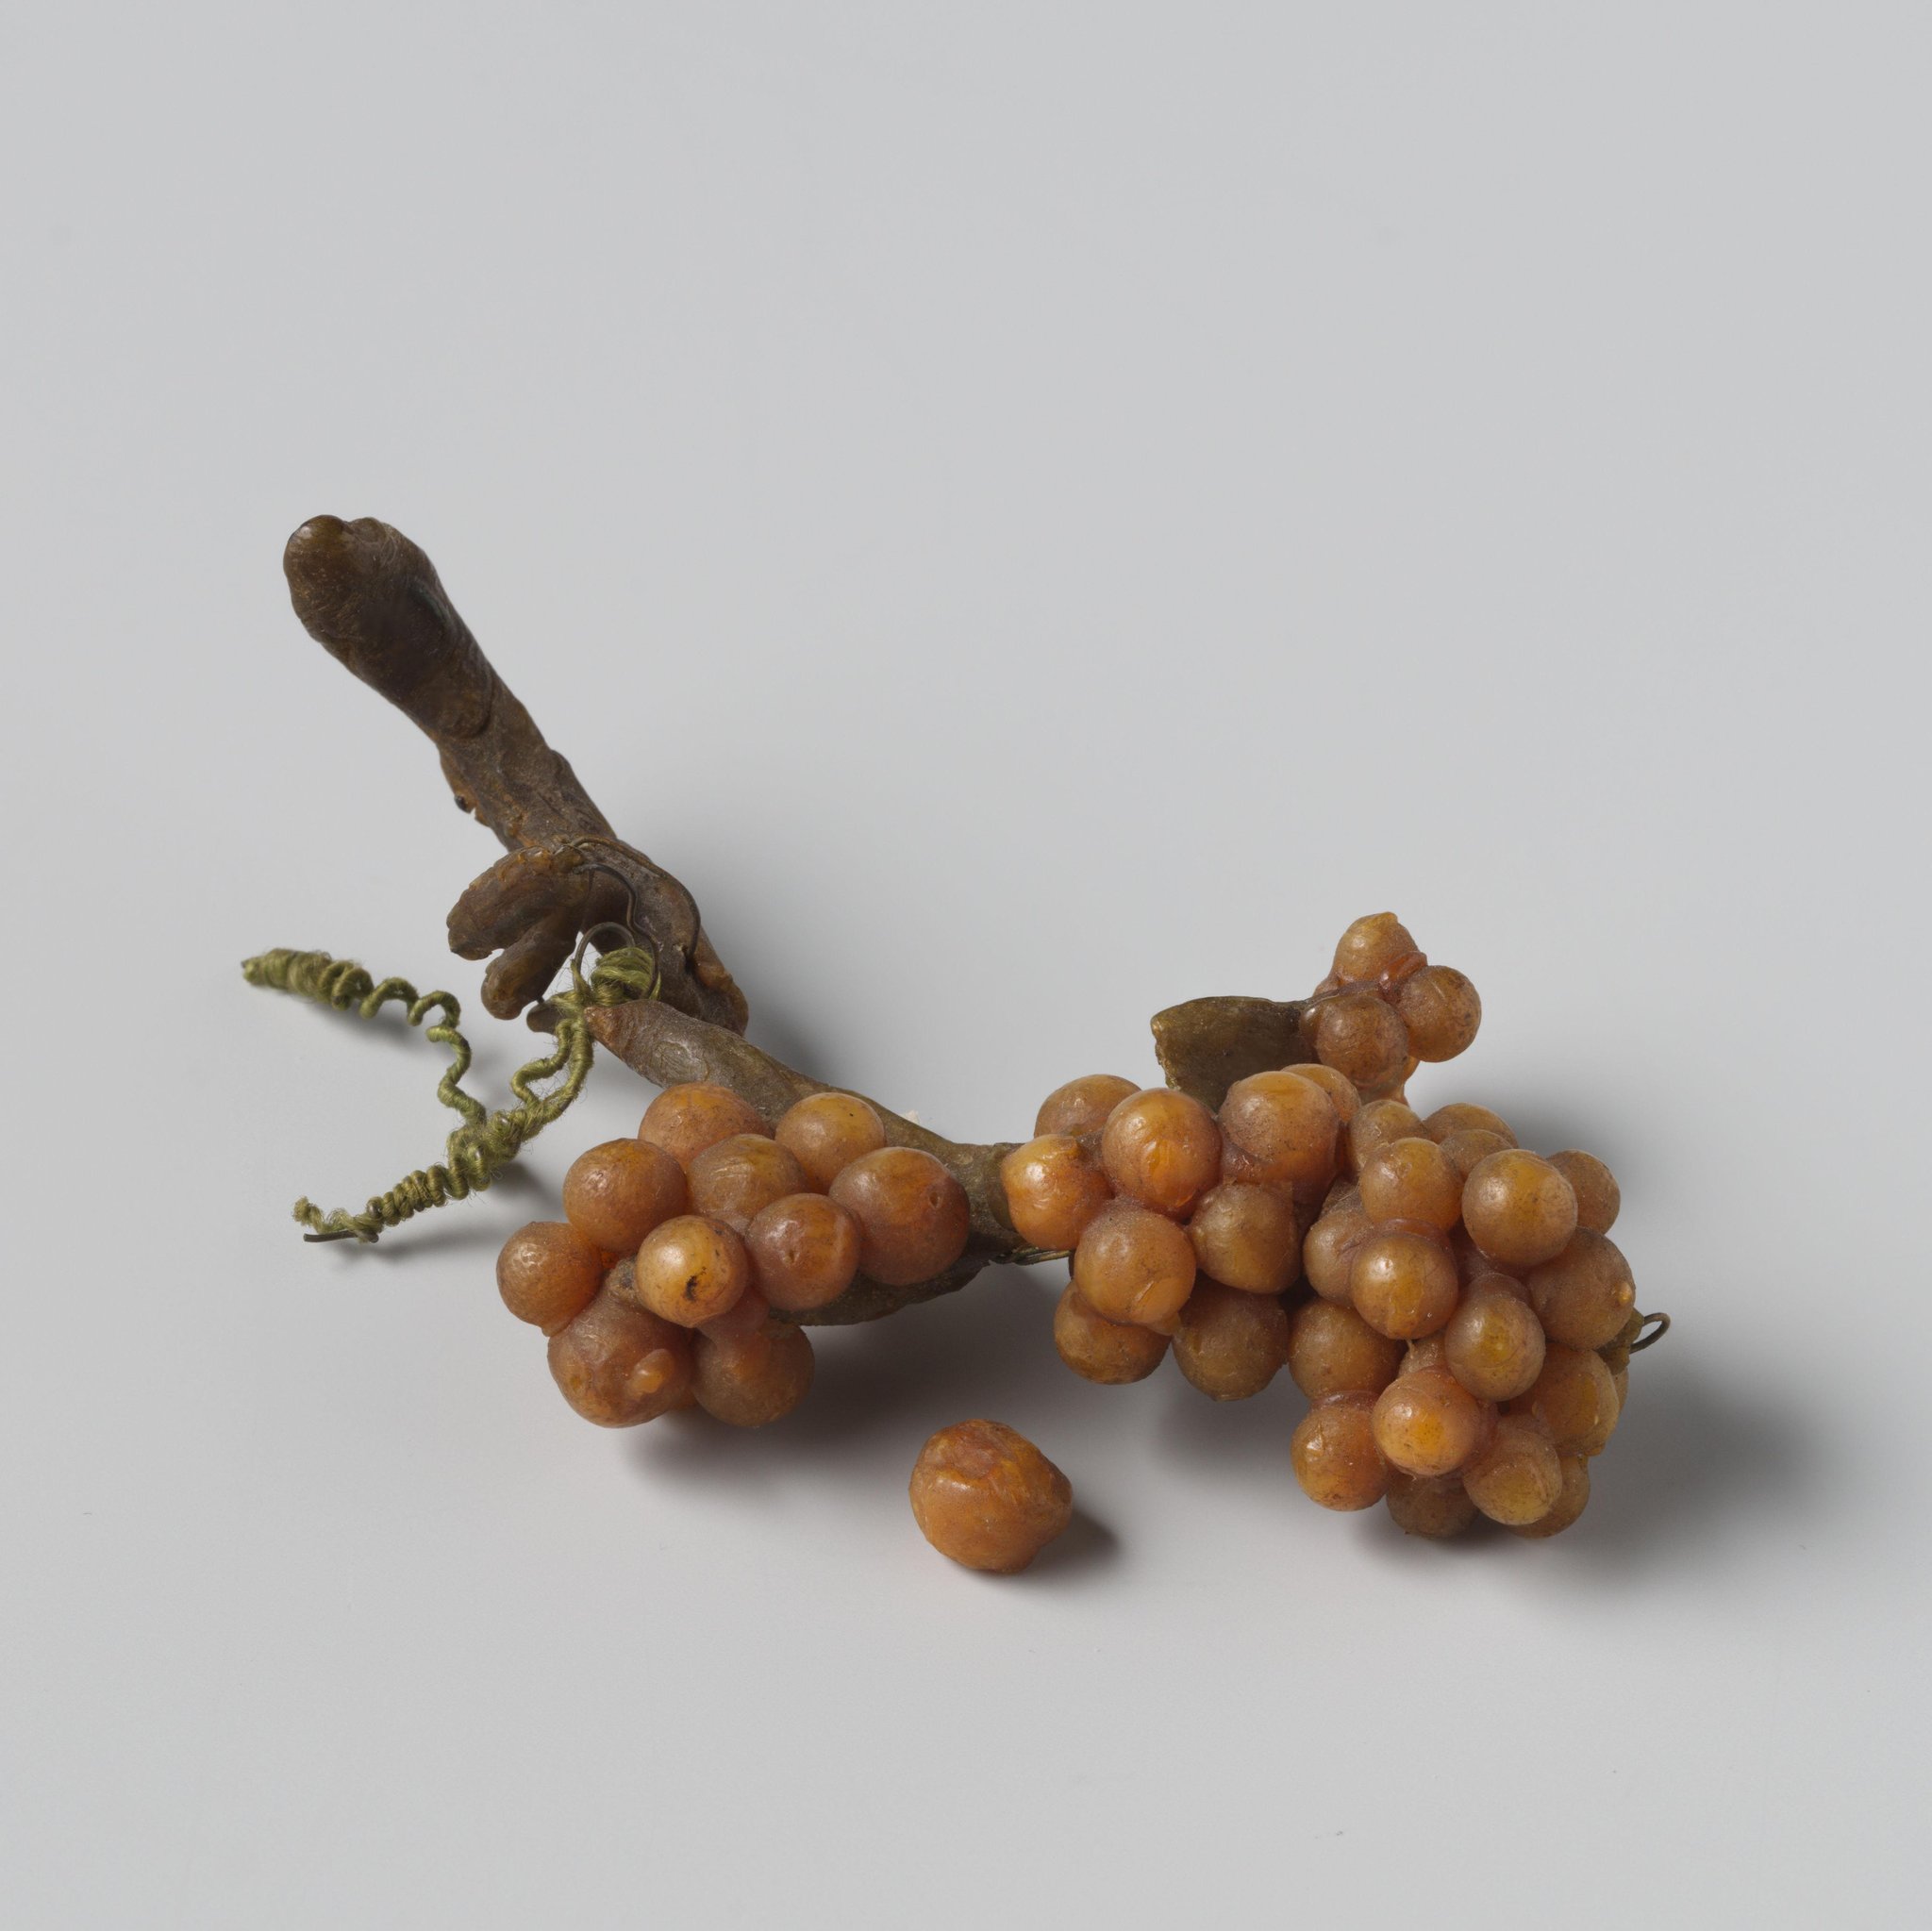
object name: food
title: Druiventros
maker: Anonymous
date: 1675-1699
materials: metal thread, wax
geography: amsterdam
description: Druiventros, vervaardigd van was en verstevigd met metaaldraad.